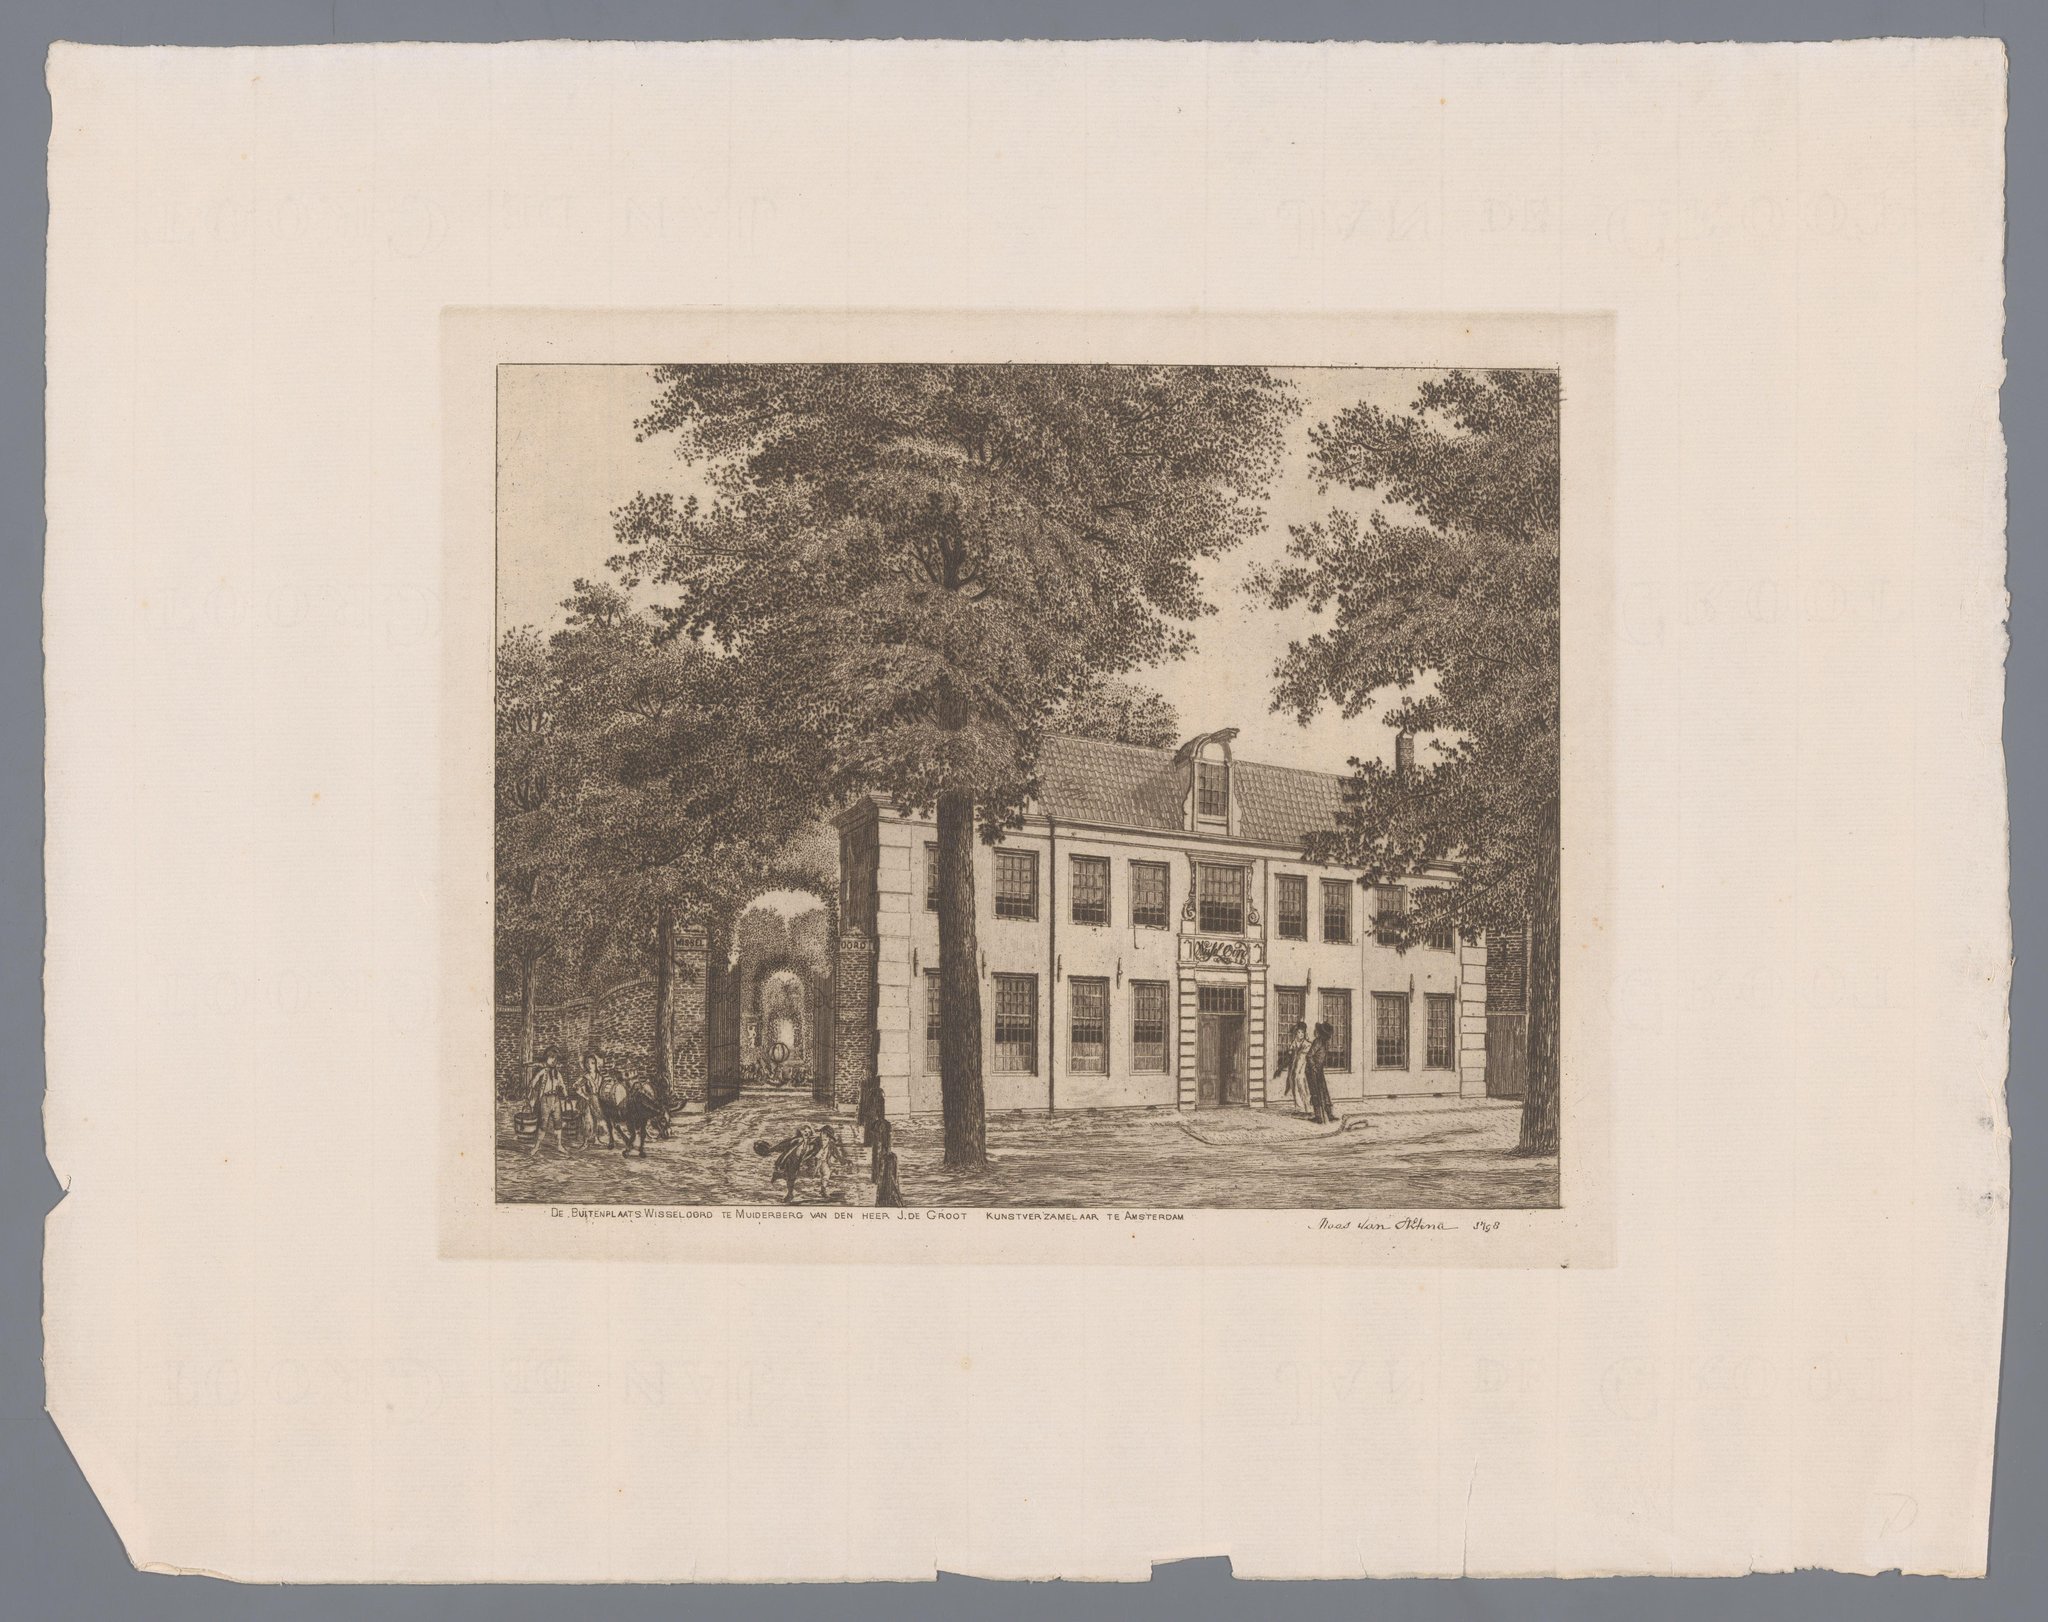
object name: print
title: Wisseloord te Muiderberg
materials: paper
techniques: etching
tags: rural housing, e.g. country-house, villa, cottage